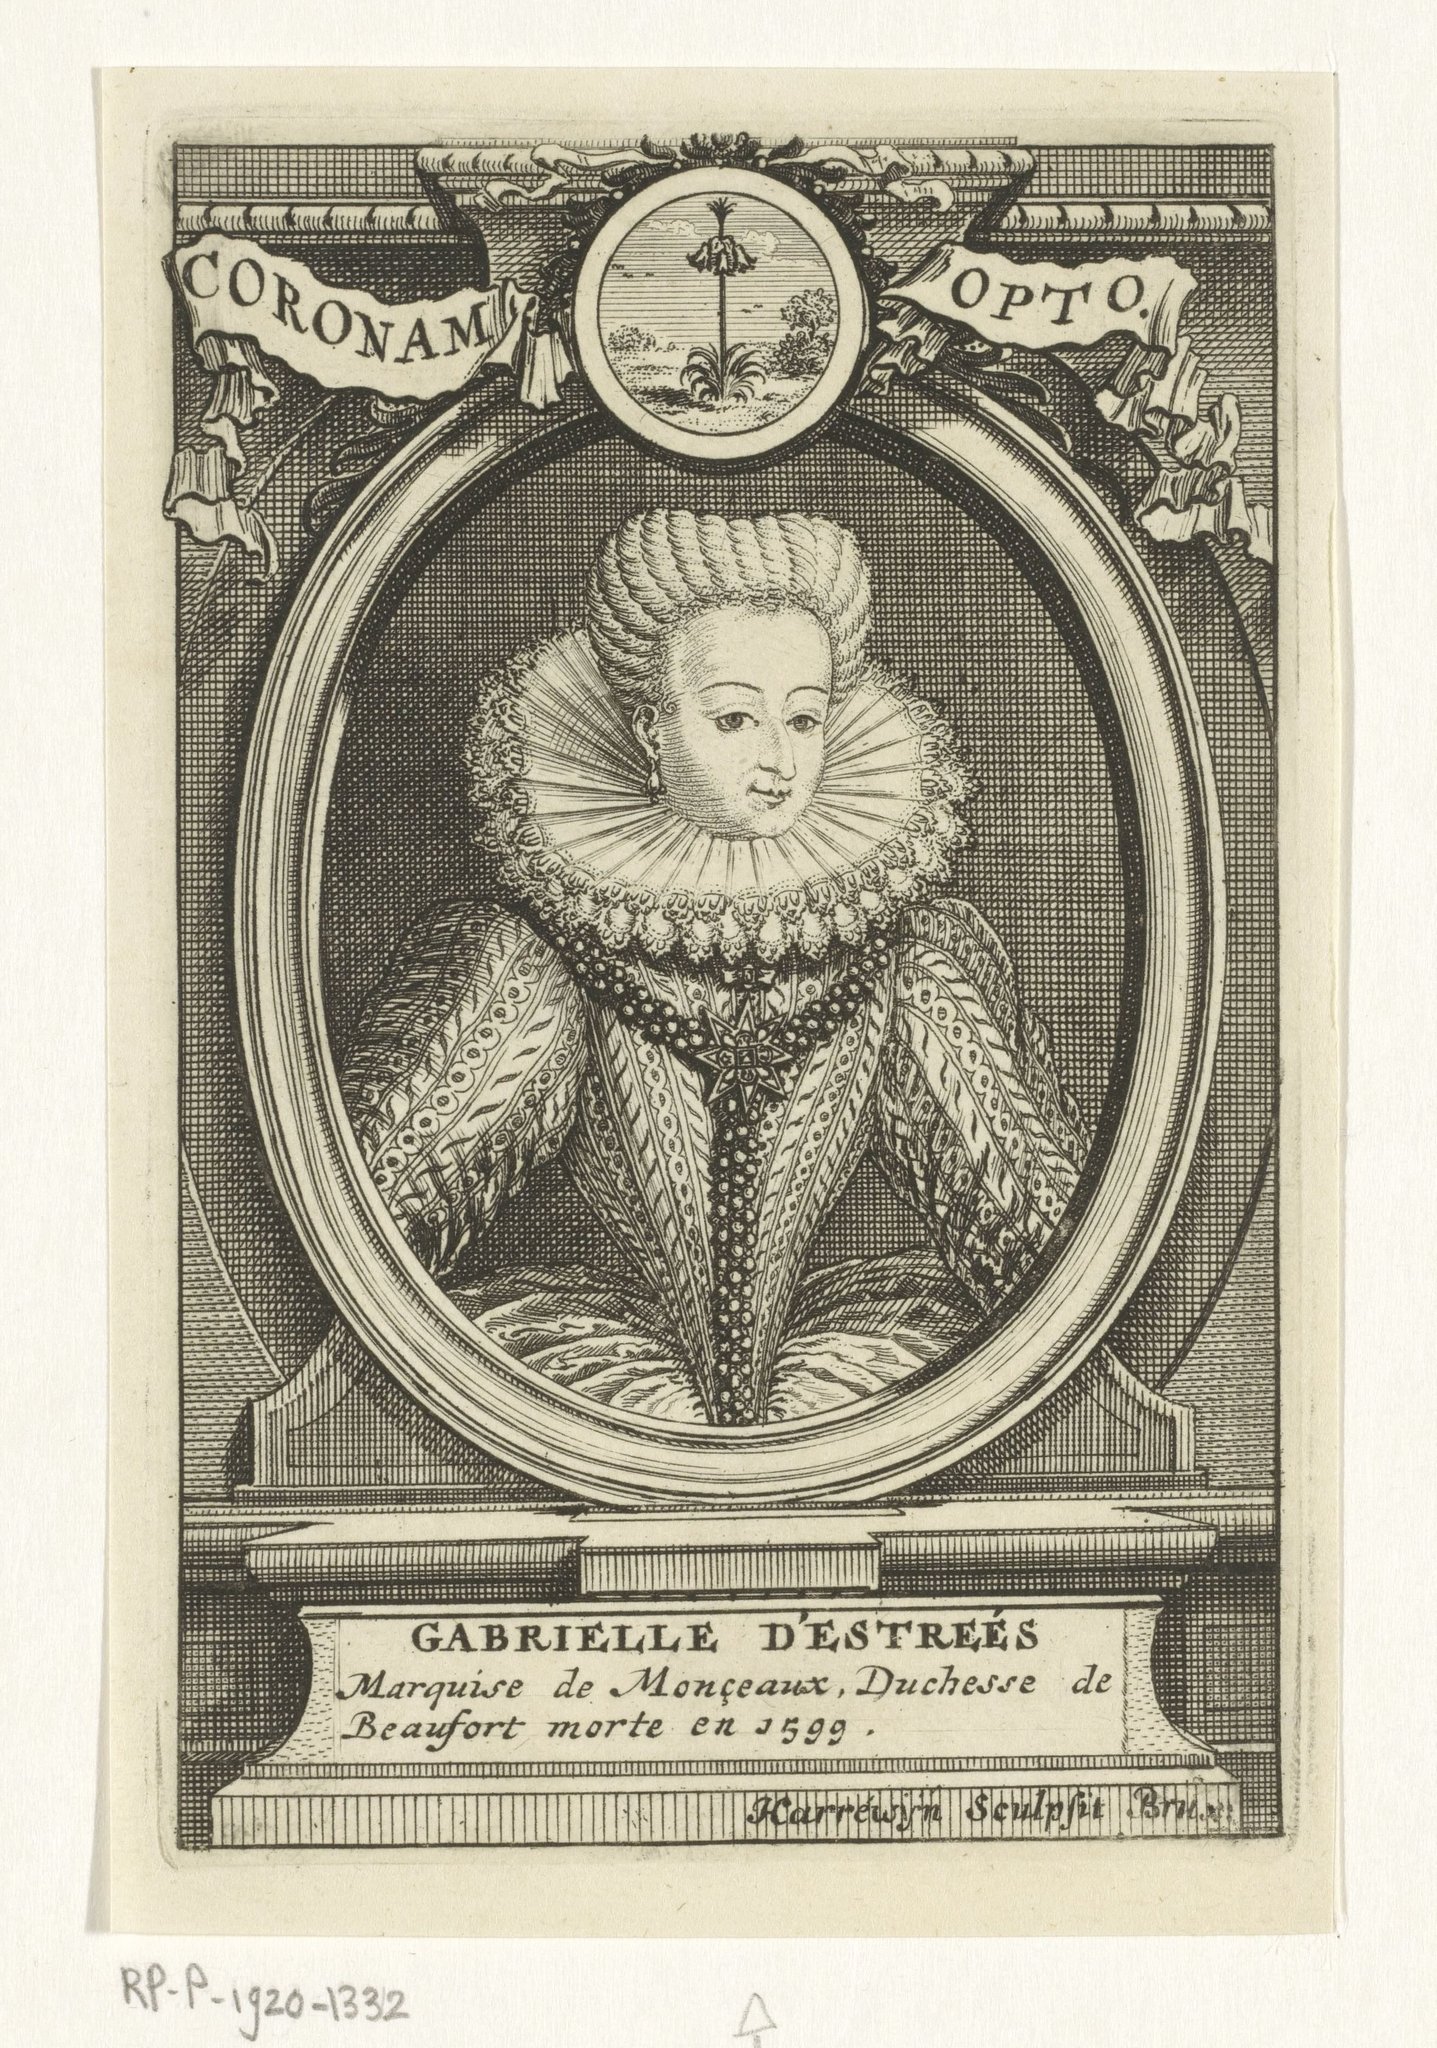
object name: print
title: Portret van Gabrielle d'Estrées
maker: jacobus harrewijn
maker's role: print maker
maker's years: 1660-1740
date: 1695-1714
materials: paper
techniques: etching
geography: brussels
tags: hertogin, markiezin, gabrielle d'estreés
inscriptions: collector's mark: Lugt 2228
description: Portret ten halven lijve van Gabrielle d'Estrées in een ovaal. Boven het portret een afbeelding van een bloem en de spreuk: Coronam opto. Onder het portret drie regels in het Frans.